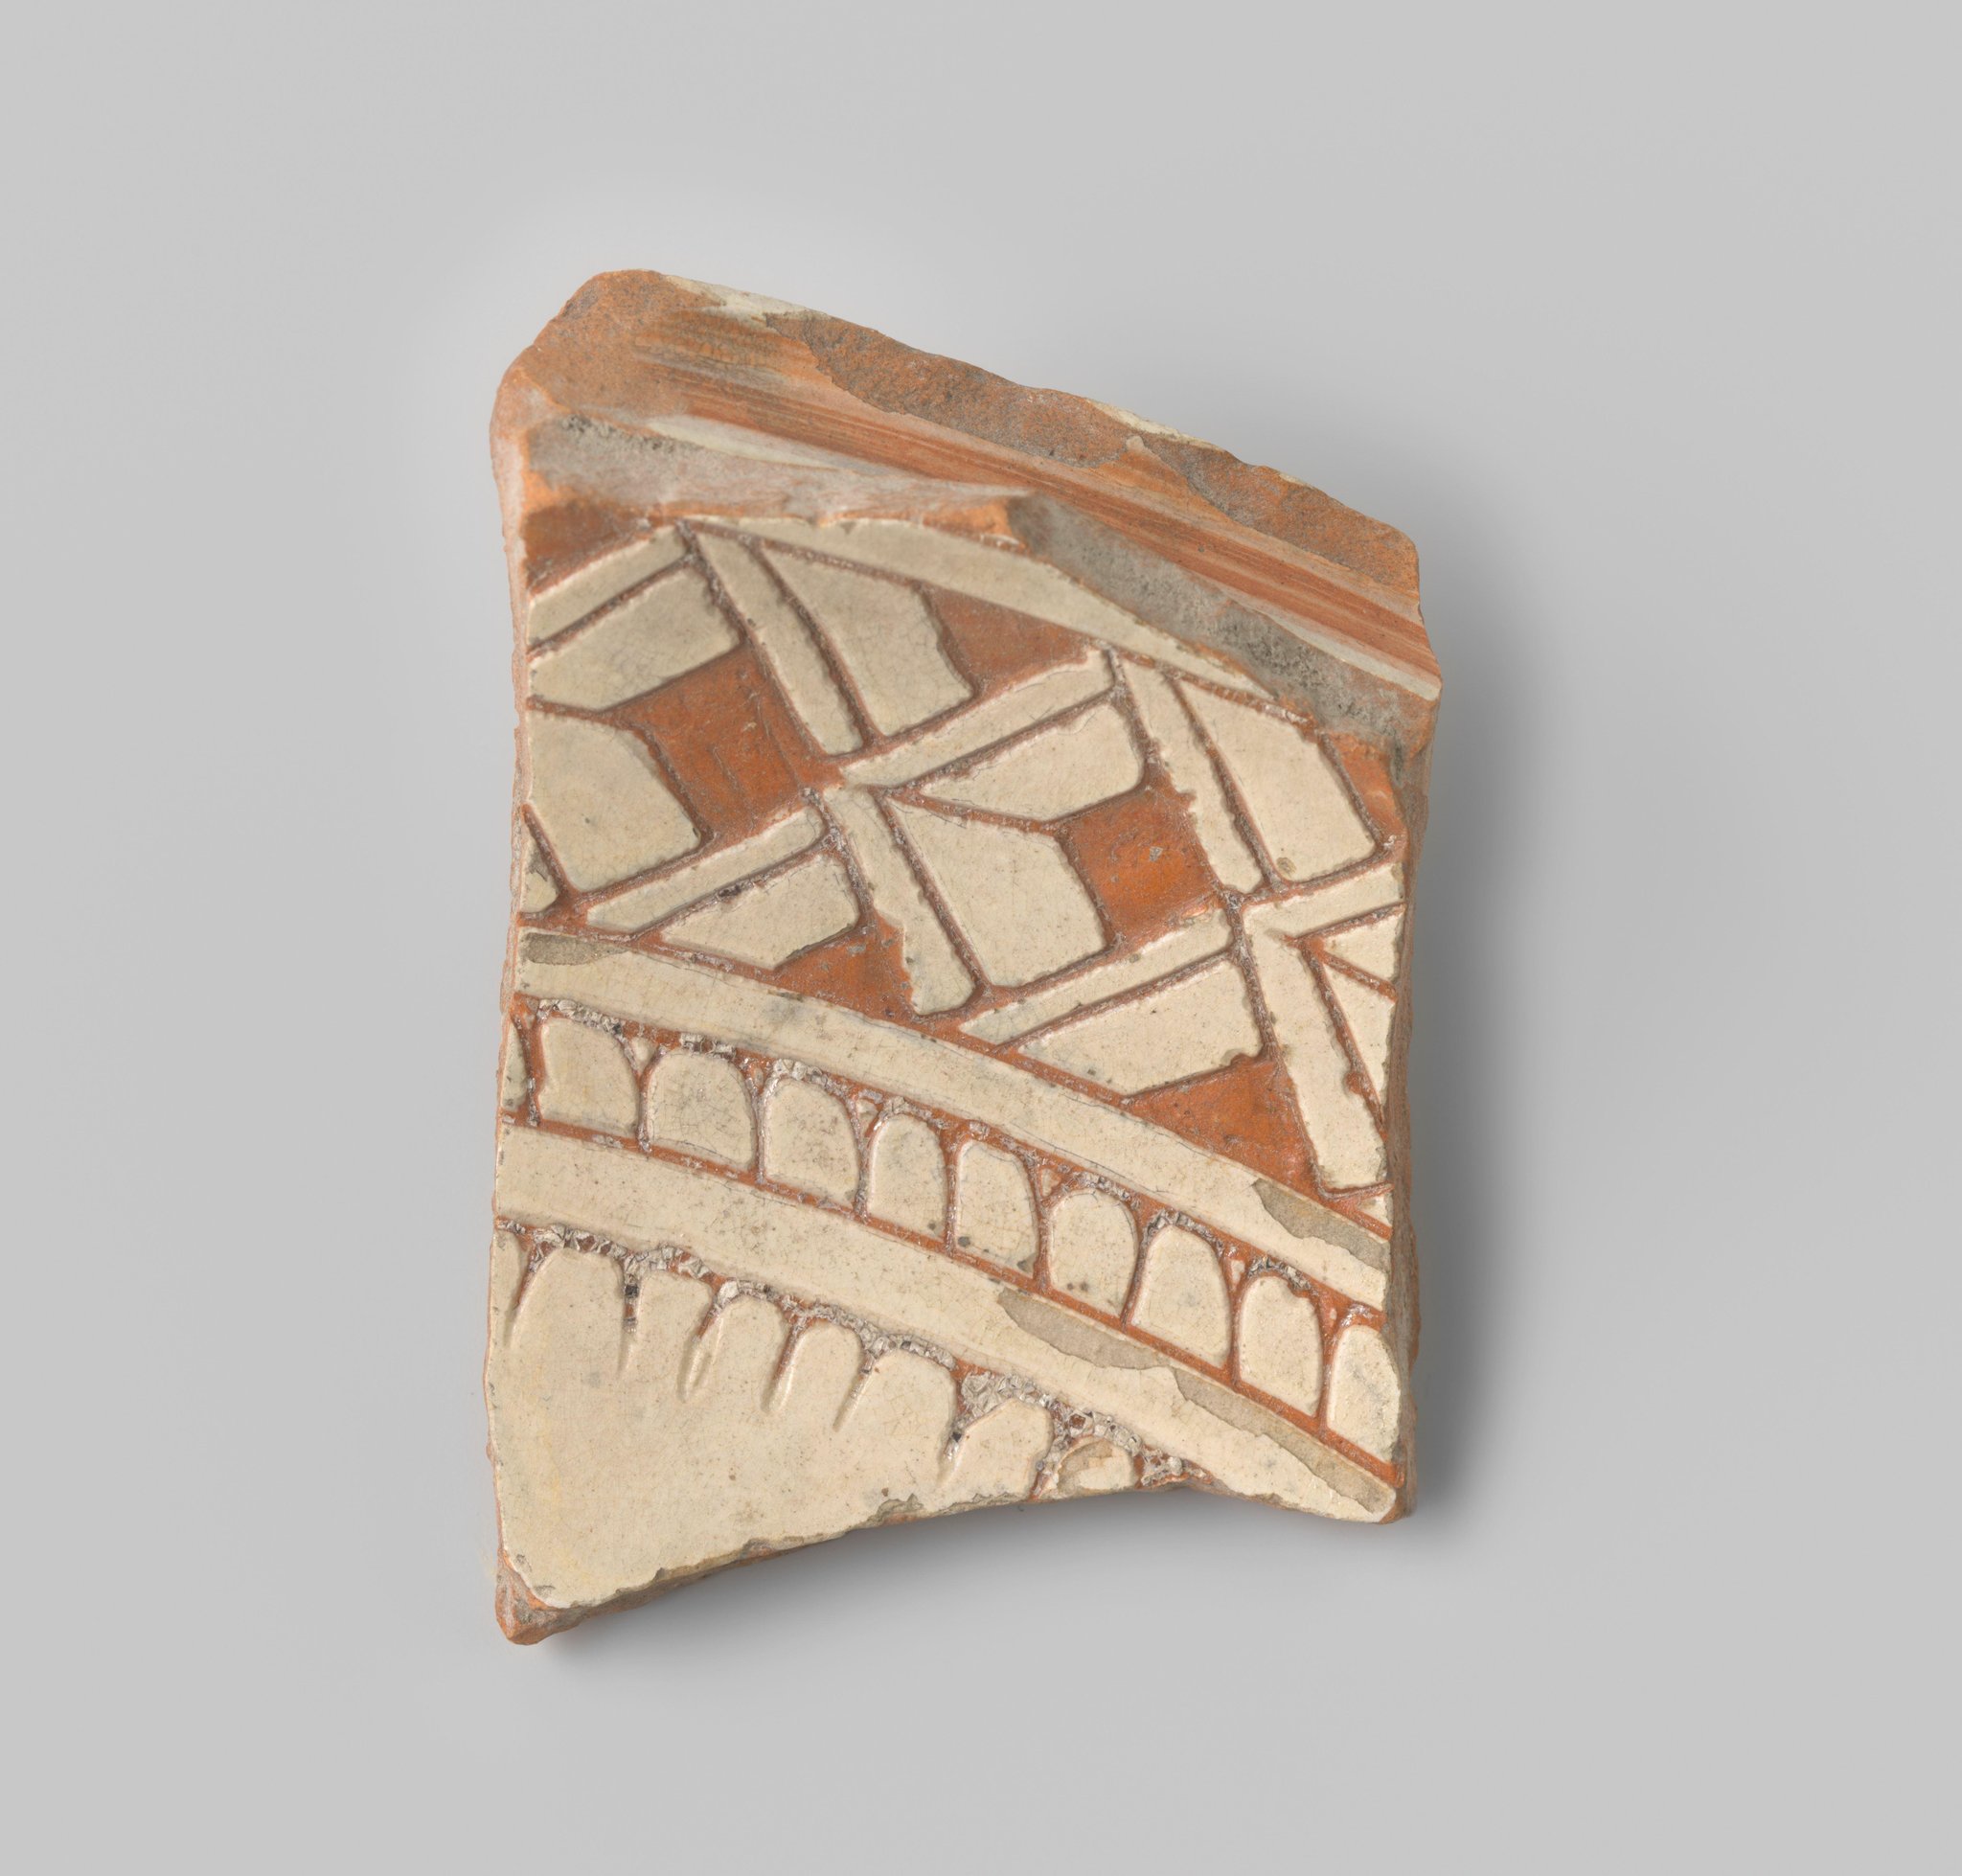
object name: sherd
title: Fragment van een schotel met roodbakkende scherf, met in sgrafitto-techniek in wit glazuur bloemvormen en geometrische vormenaan de voor- en achterzijde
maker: Anonymous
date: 1200-1899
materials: earthenware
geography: italy